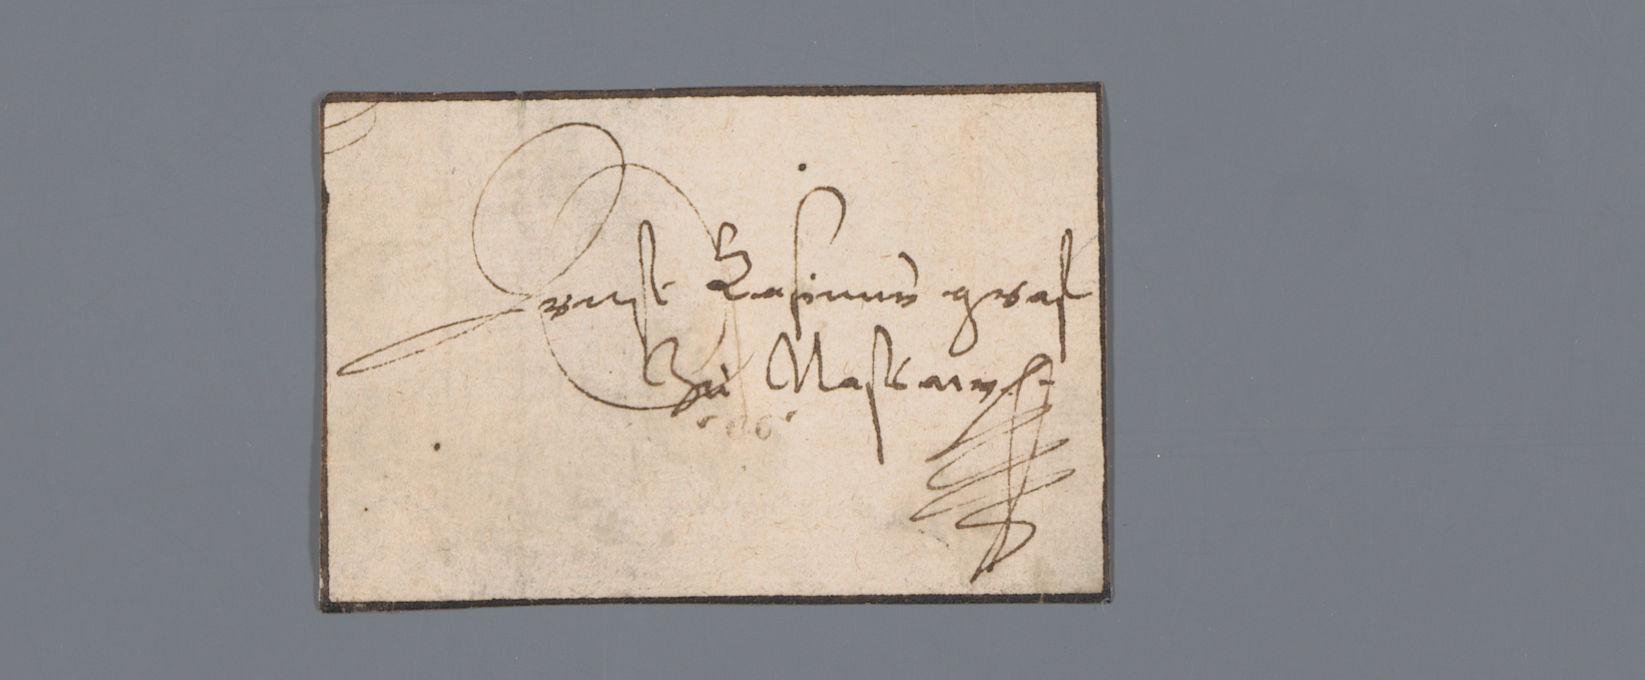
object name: sheet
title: Document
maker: ernst casimir graaf van nassau-dietz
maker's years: 1573-1632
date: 1600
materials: ink, paper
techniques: writing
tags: ernst casimir graaf van nassau-dietz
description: Handtekening in bruine inkt (van Ernst Casimir van nassau-dietz) ob blaadje papier. Gesigneerd: Ernst Casimir graf Zu Nassau.